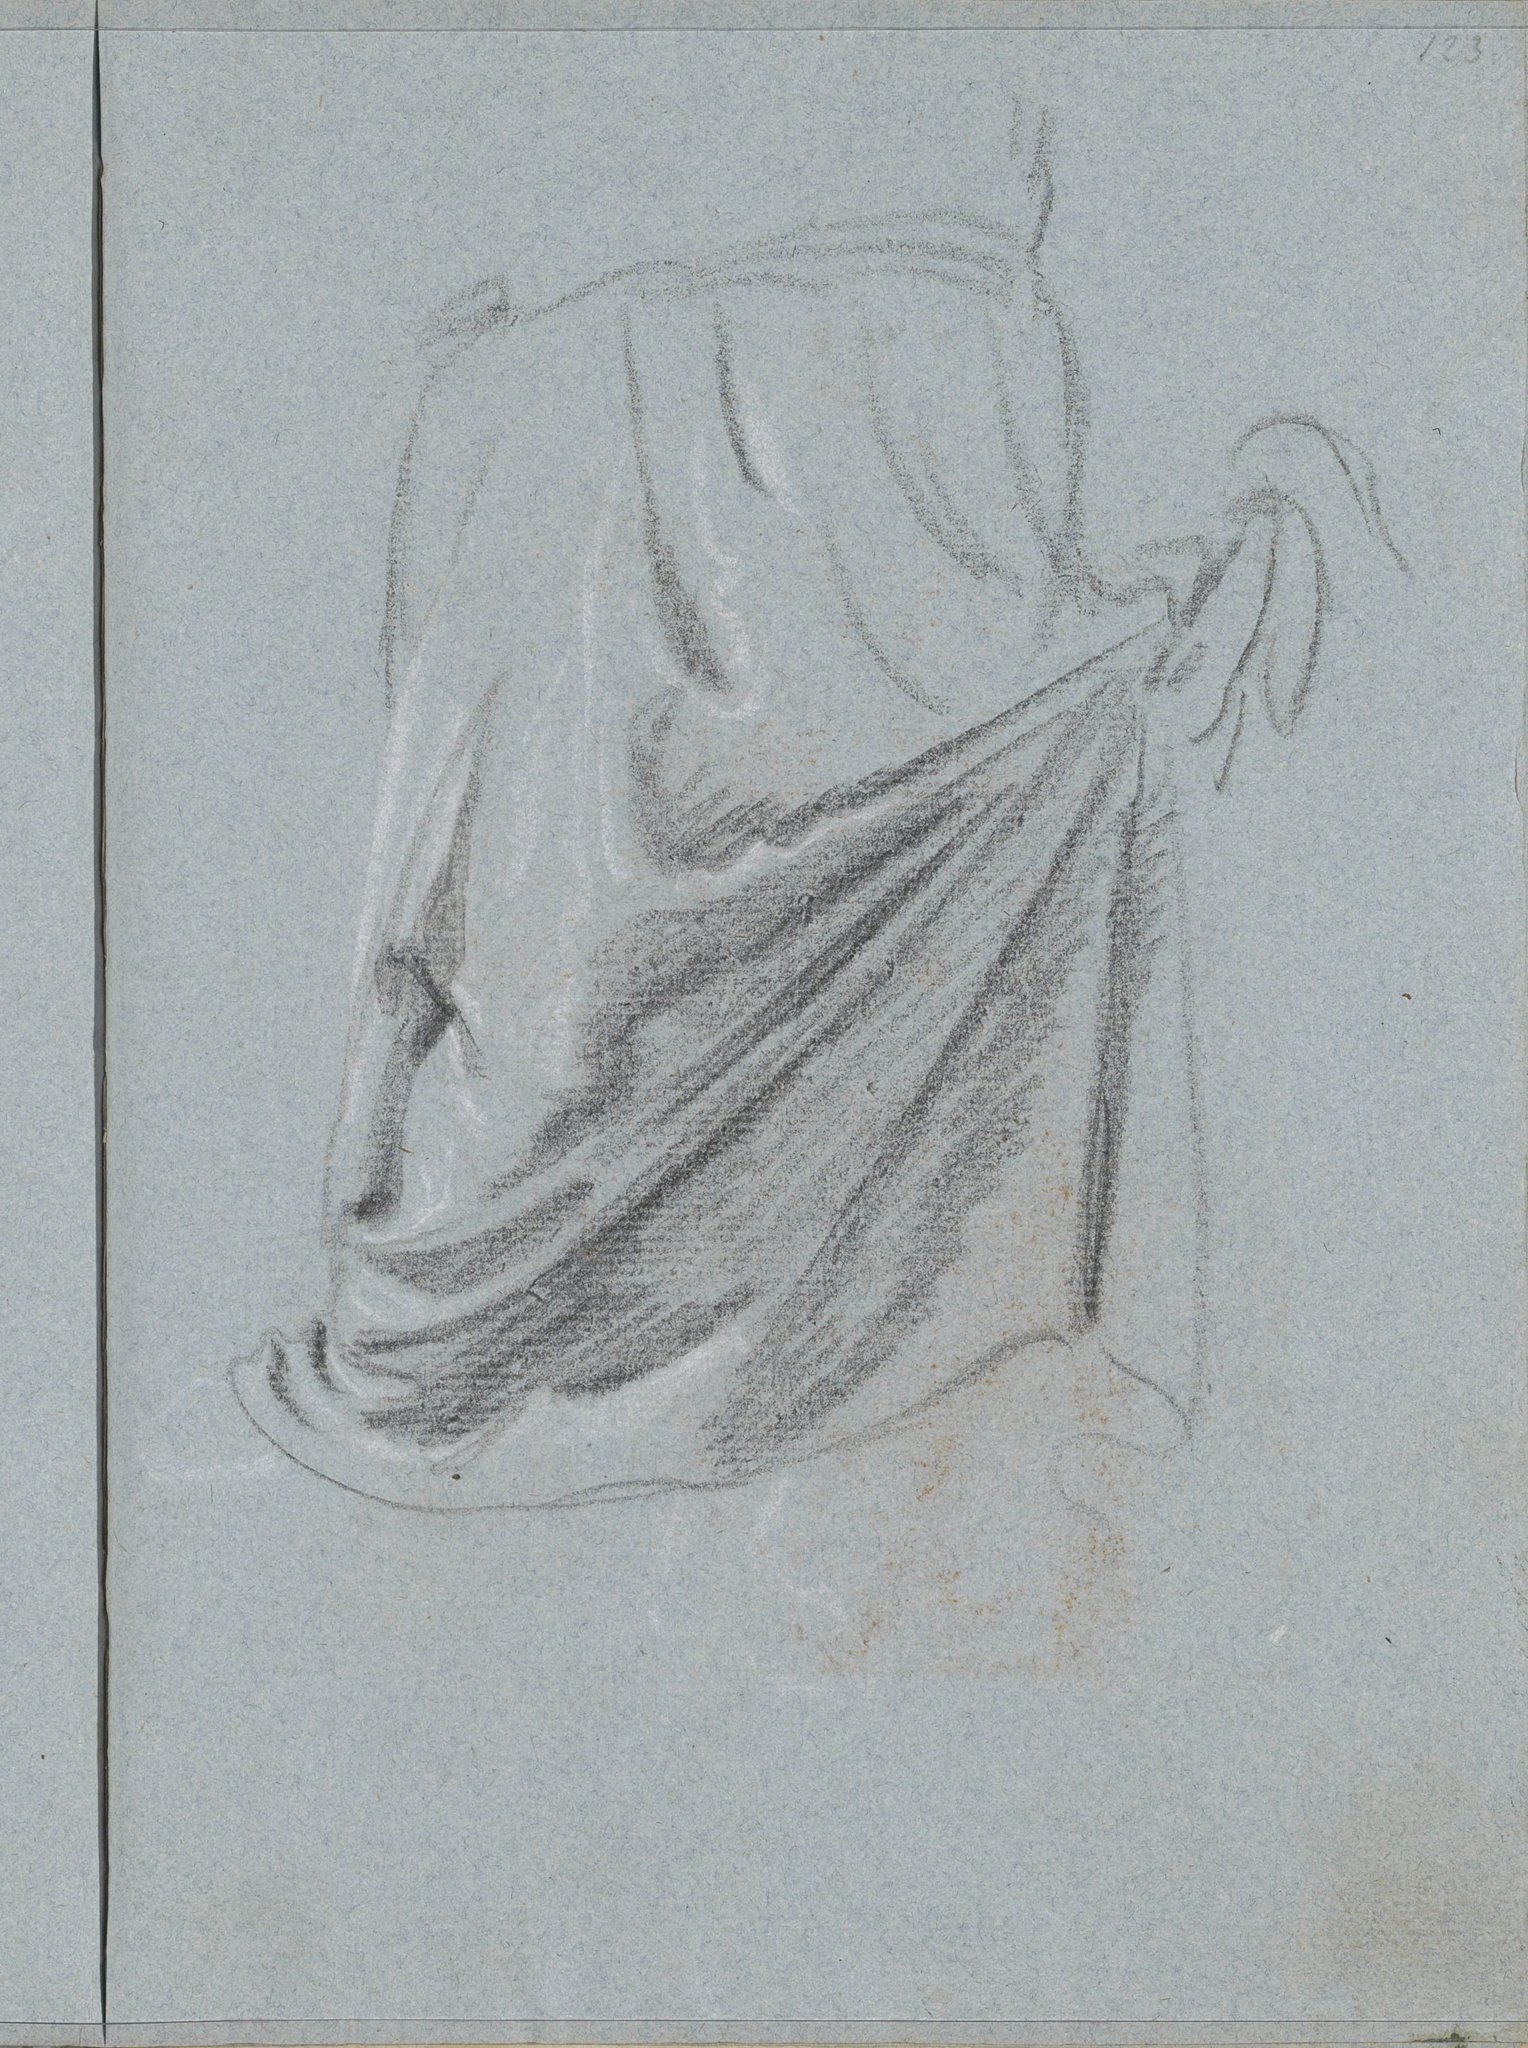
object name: sketchbook leaf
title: Draperie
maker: lorenzo baldissera tiepolo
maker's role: draughtsman, print maker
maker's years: 1736-1776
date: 1751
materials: chalk, paper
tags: drapery, draped garment, 'gewandgebung'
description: Bladzijde 123 uit een schetsboek met 158 bladzijden.